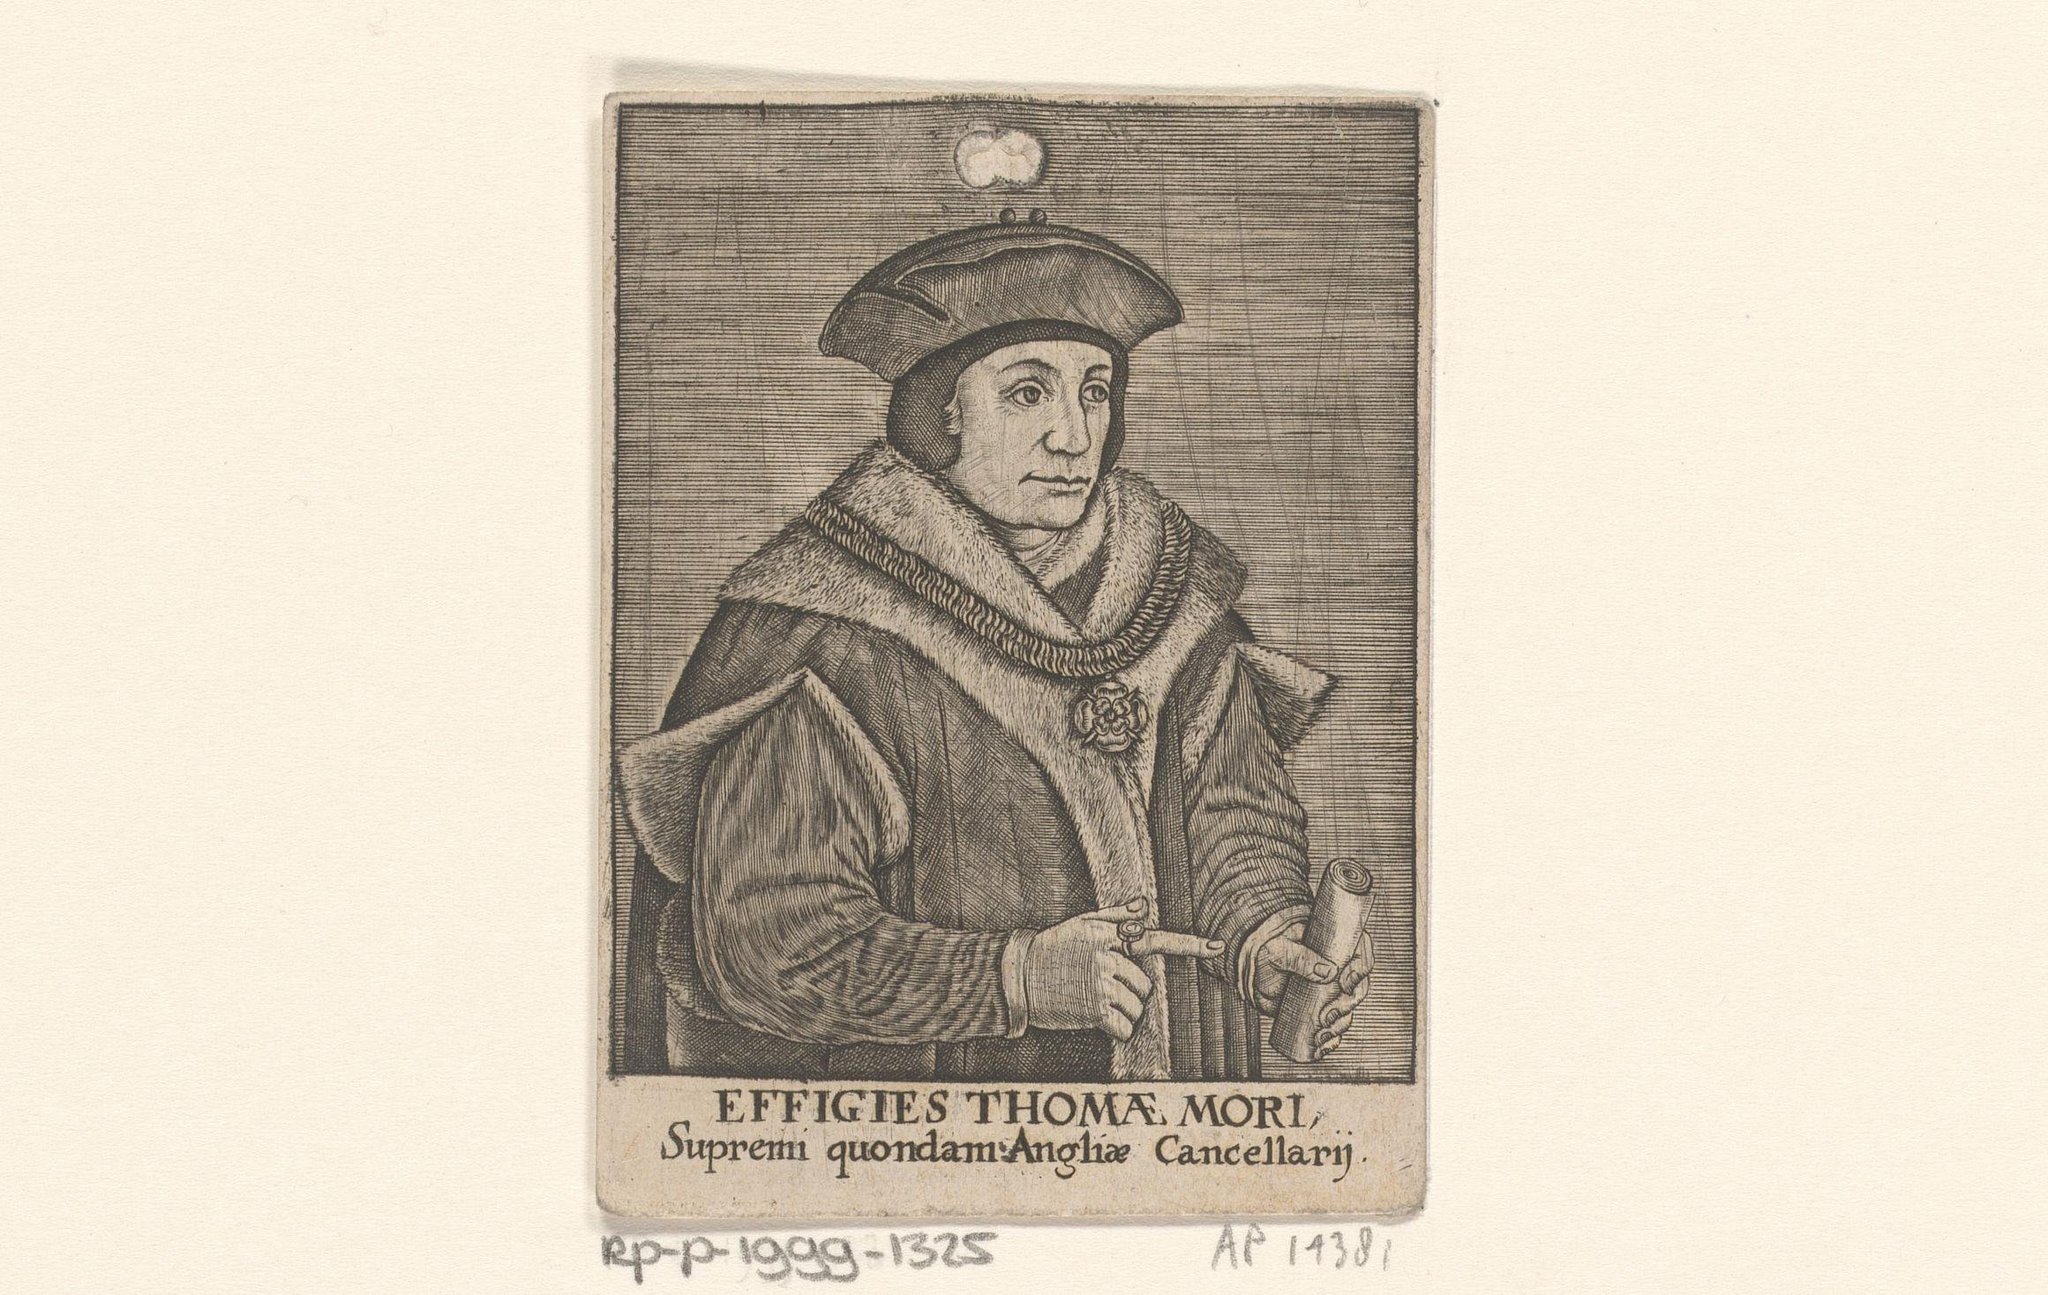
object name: print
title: Effigies Thomae Mori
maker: Anonymous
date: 1550-1650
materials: paper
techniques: engraving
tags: london, theologian, historical persons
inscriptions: collector's mark: Lugt 2228, collector's mark: Lugt 2760